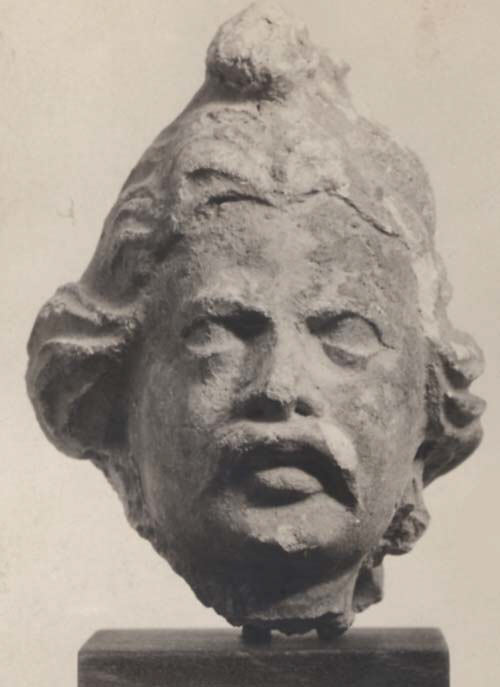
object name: wall decoration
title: Head of an Iranian Nomad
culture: gandhara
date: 201-500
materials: plaster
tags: gandhara,heads,men